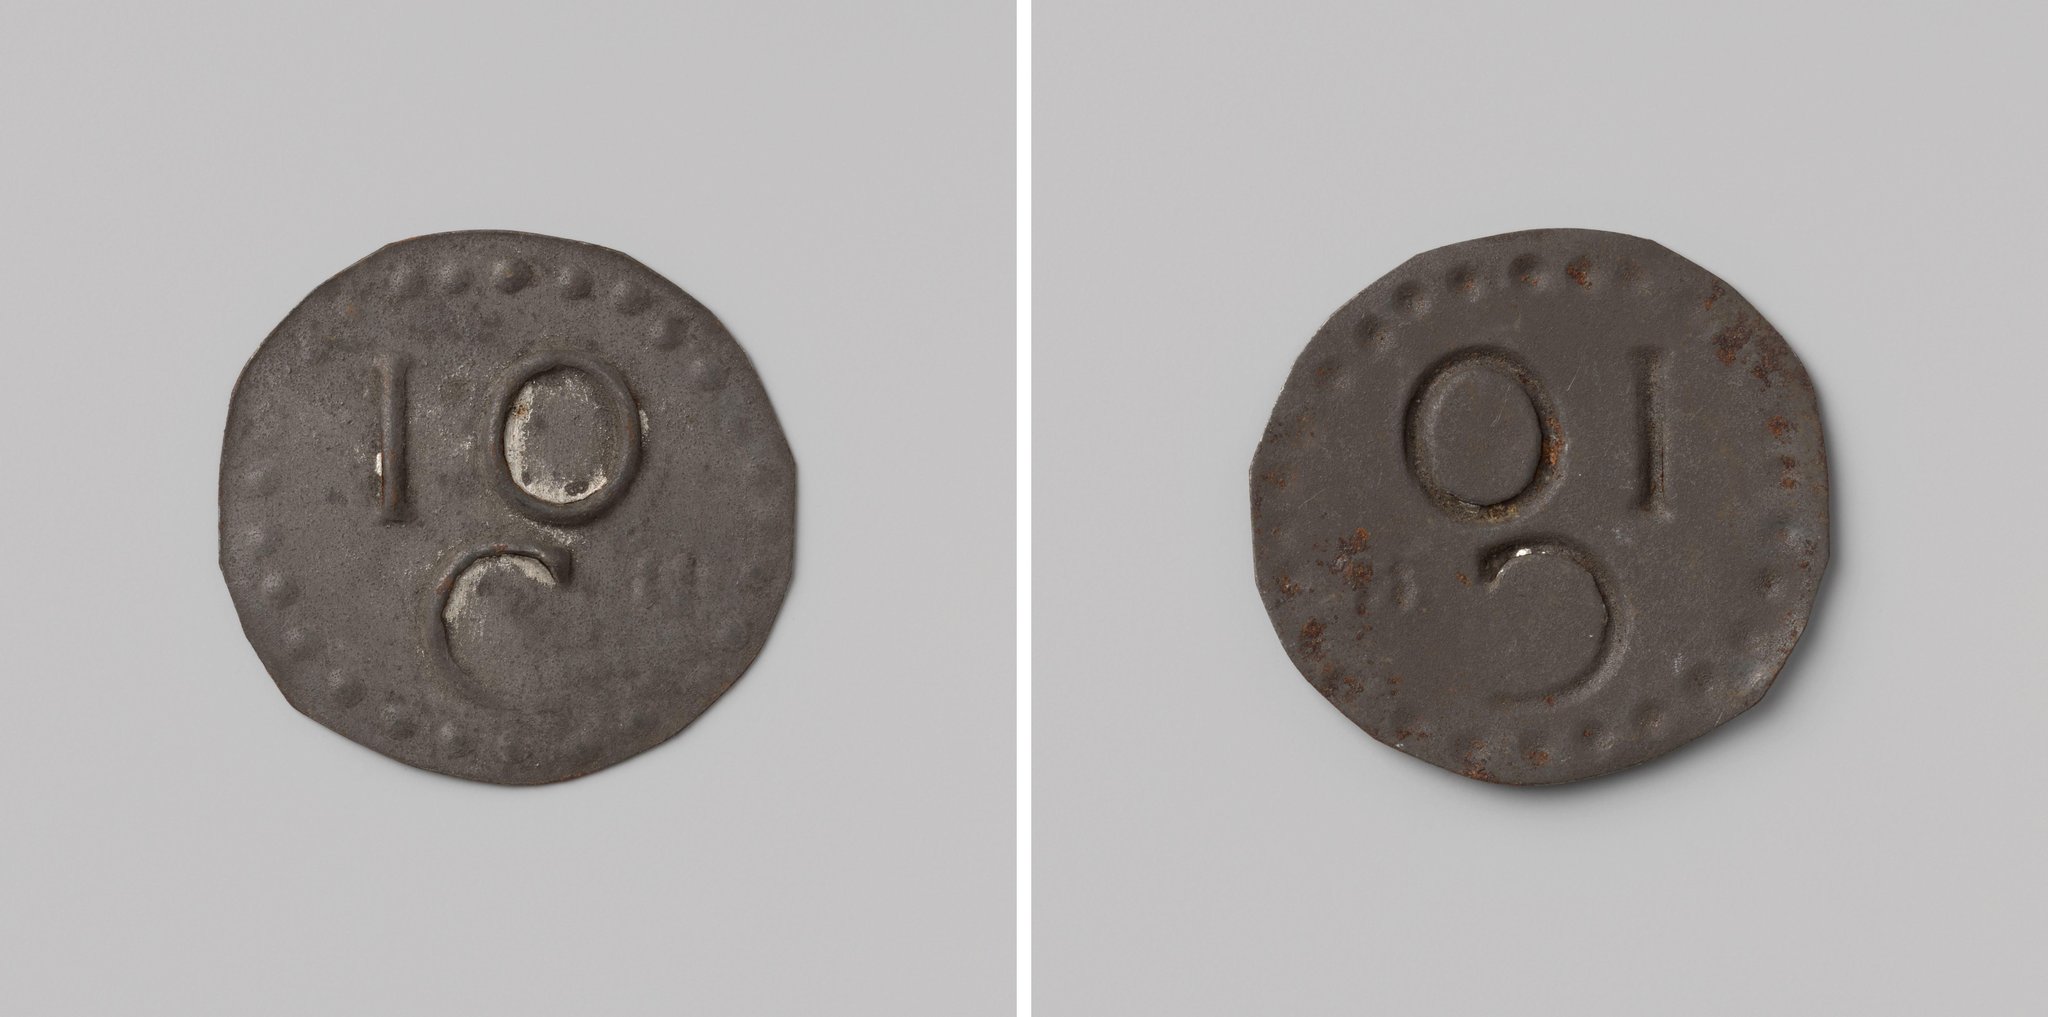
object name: monetary token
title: Strafgevangenis Ommerschans, huismunt geslagen op last van de Maatschappij van Weldadigheid ter waarde van tien cent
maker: Anonymous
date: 1822-1830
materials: silver, metal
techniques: silvering, striking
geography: ommerschans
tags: maatschappij van weldadigheid, ommerschans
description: eenzijdige munt. Voorzijde: waardeaanduiding binnen parelrand; links: merk. Keerzijde: blanco